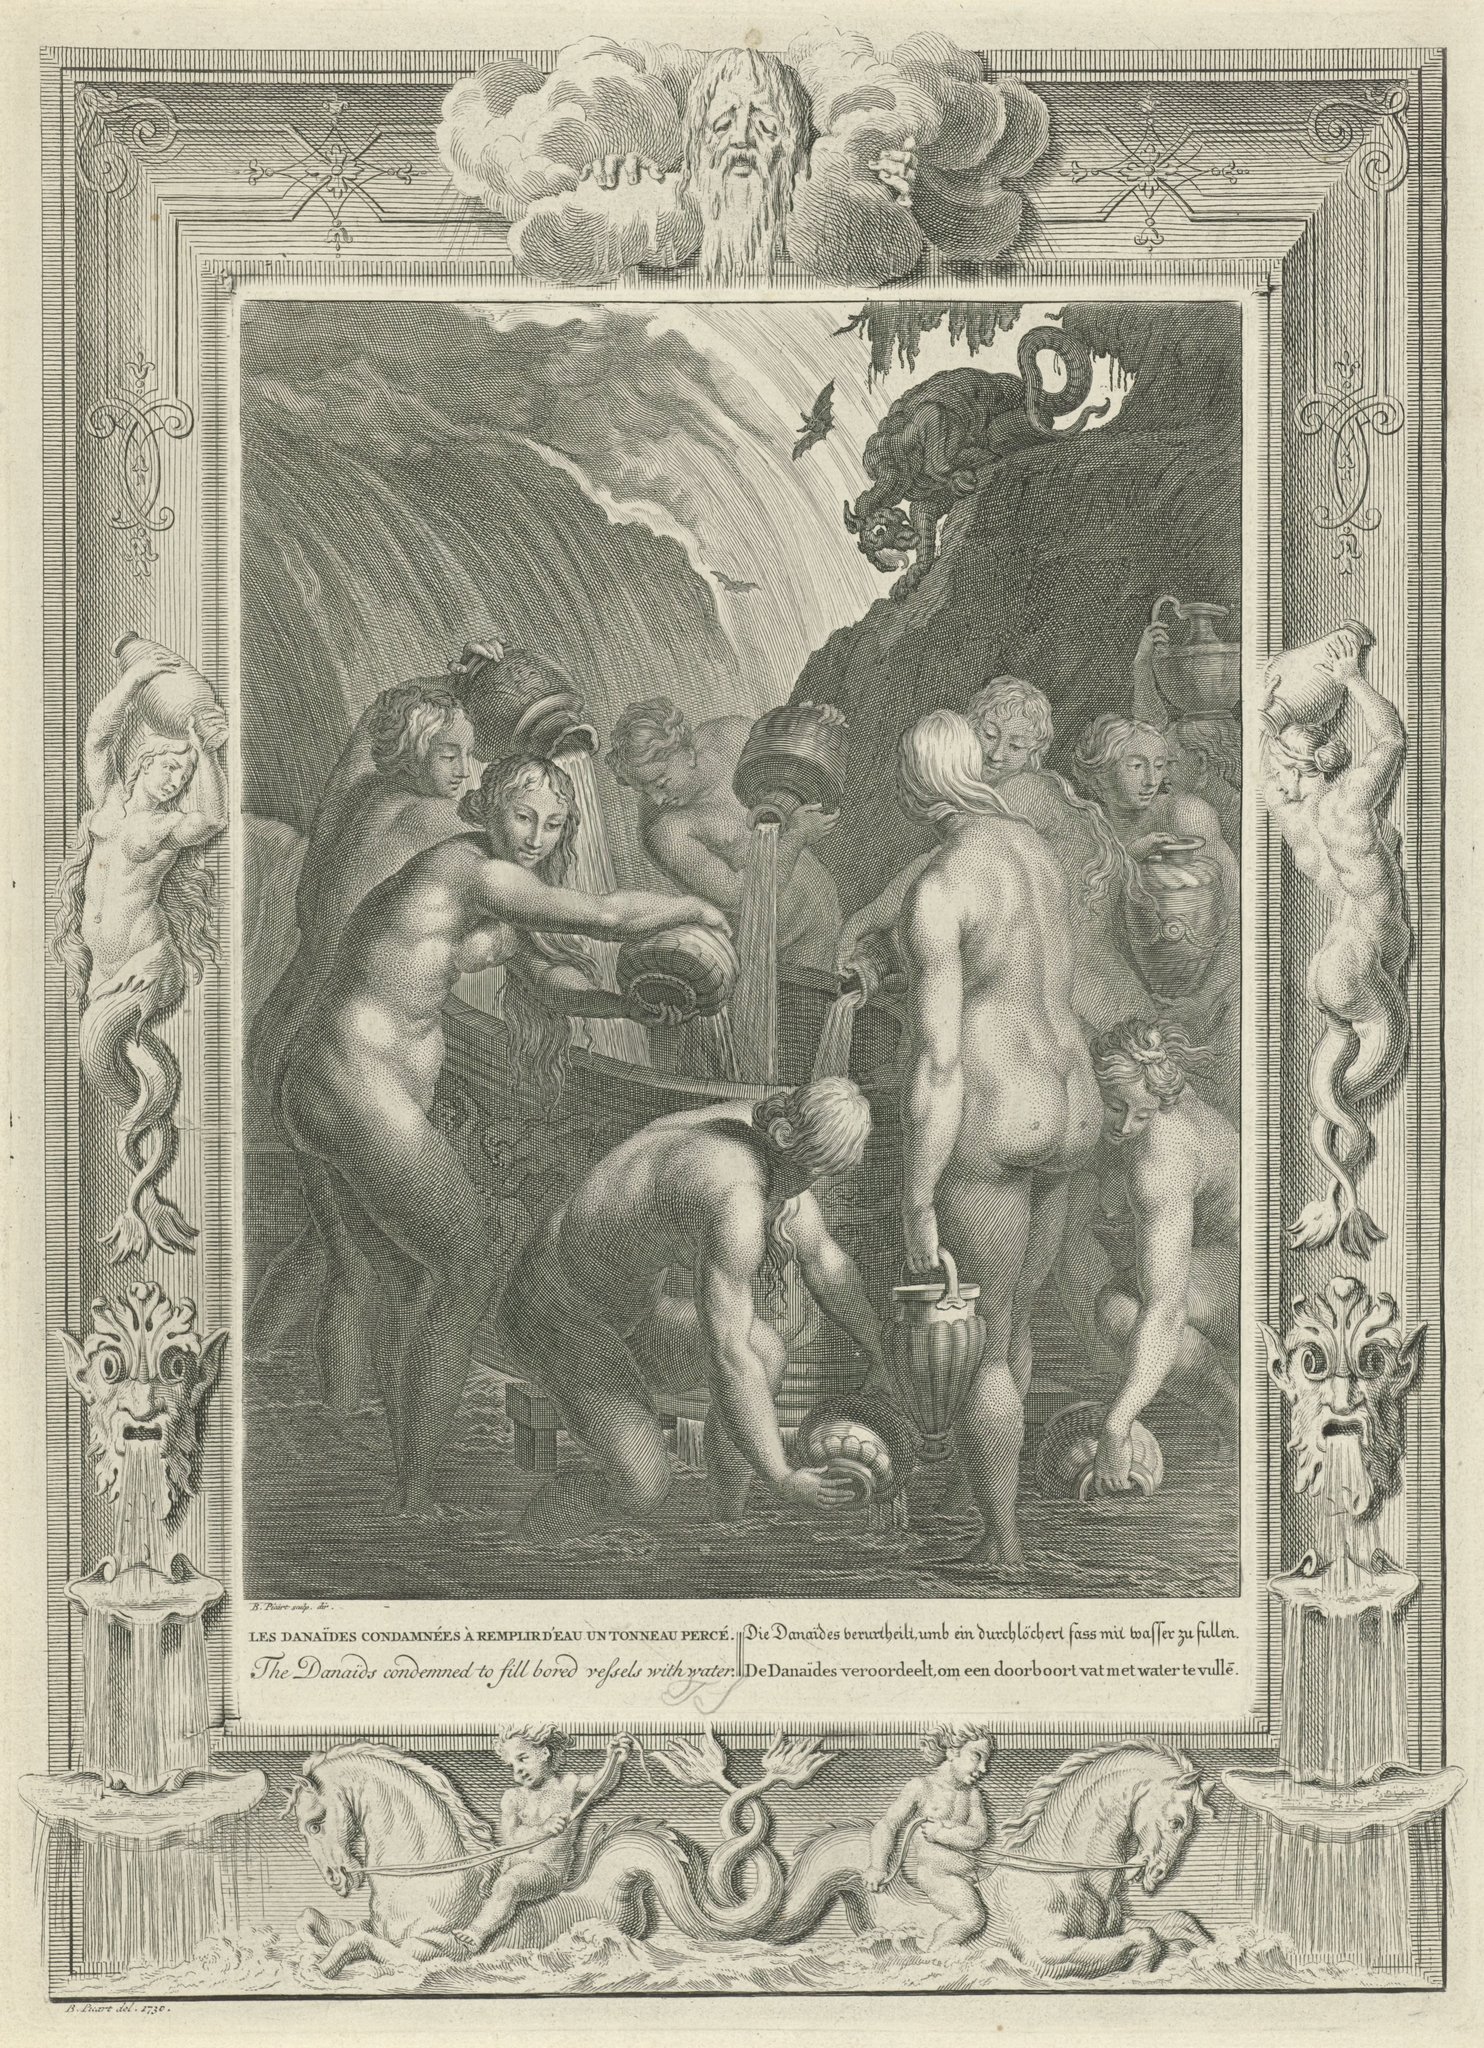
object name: print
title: De Danaïden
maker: bernard picart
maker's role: draughtsman, print maker, publisher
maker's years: 1673-1733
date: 1730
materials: paper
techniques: engraving, etching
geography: amsterdam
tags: the danaids pouring water into a perforated vessel, scrollwork, strapwork ~ ornament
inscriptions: collector's mark: Lugt 2228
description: De Danaïden, dochters van koning Danaos van Libië, zijn veroordeelt tot het vullen van een bodemloos vat. In de onderwereld scheppen zij met kruiken water in het vat. In de marge de titel in het Frans, Engels, Duits en Nederlands. De voorstelling is gedecoreerd met een ornamentele rand.